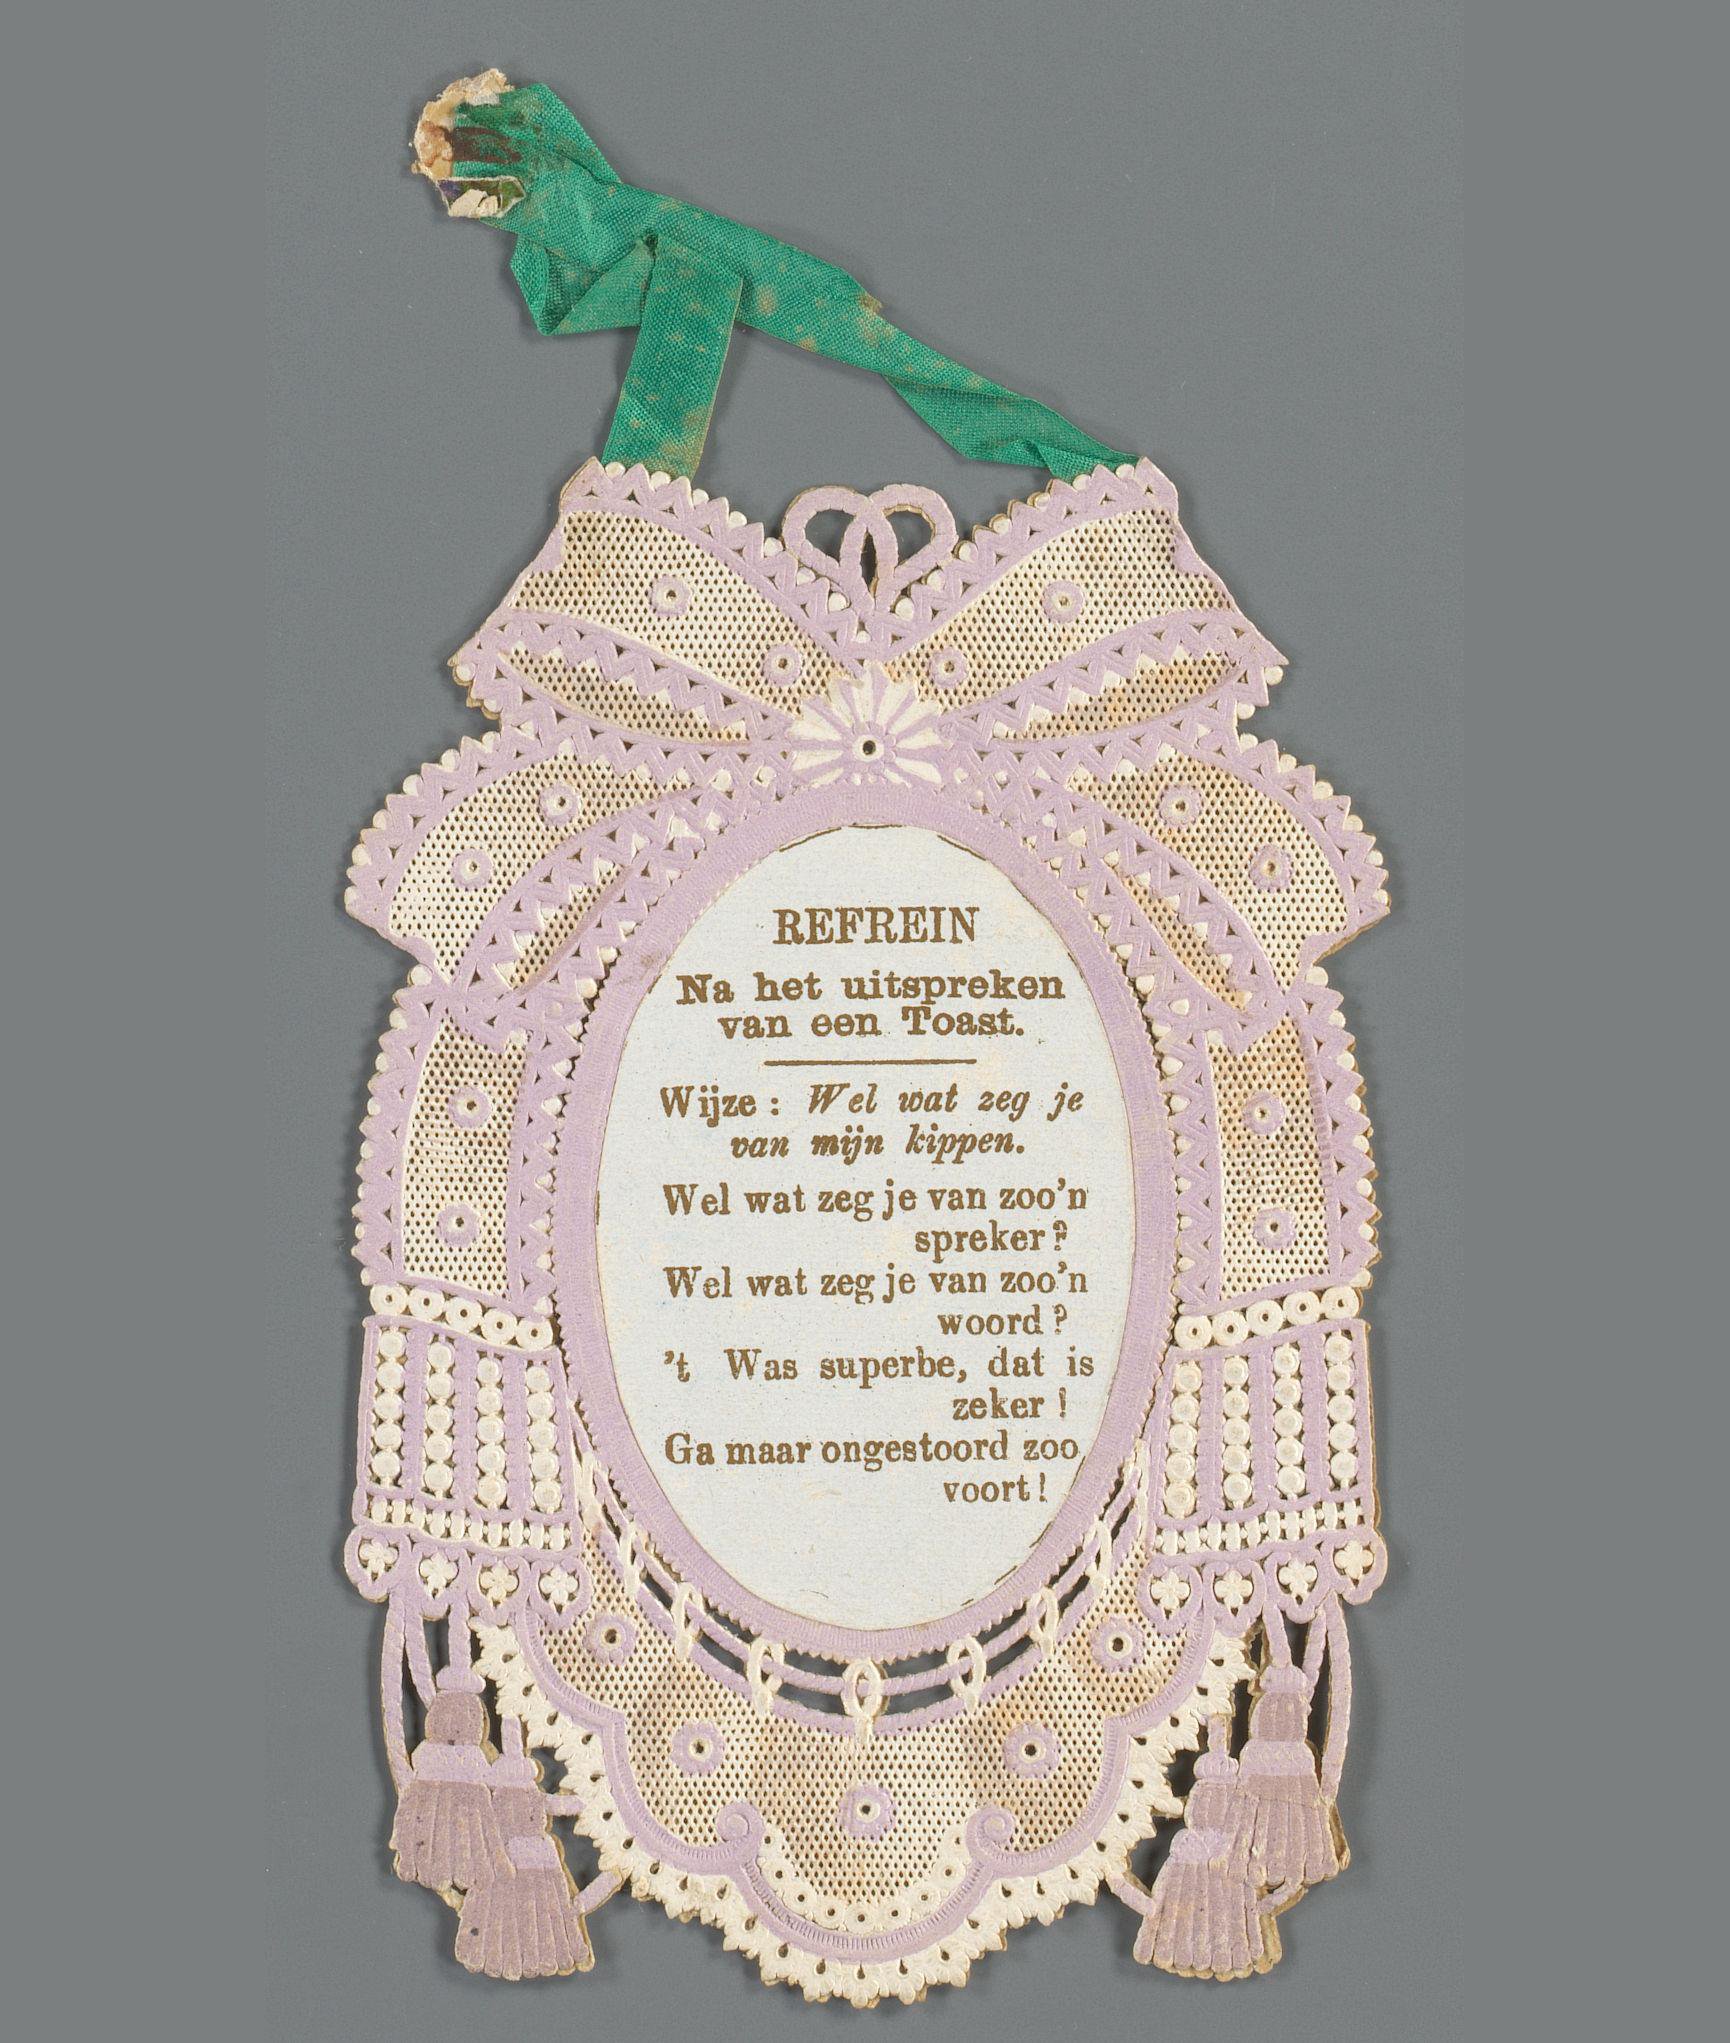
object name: map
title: Eivormige kaart met twee liedteksten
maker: Anonymous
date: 1850-1900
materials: paper, silk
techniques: printing, letterpress printing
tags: lace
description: Kaart in de vorm van een ei met daaromheen linten. In het hart van het ei op de voor- en achterzijde teksten.